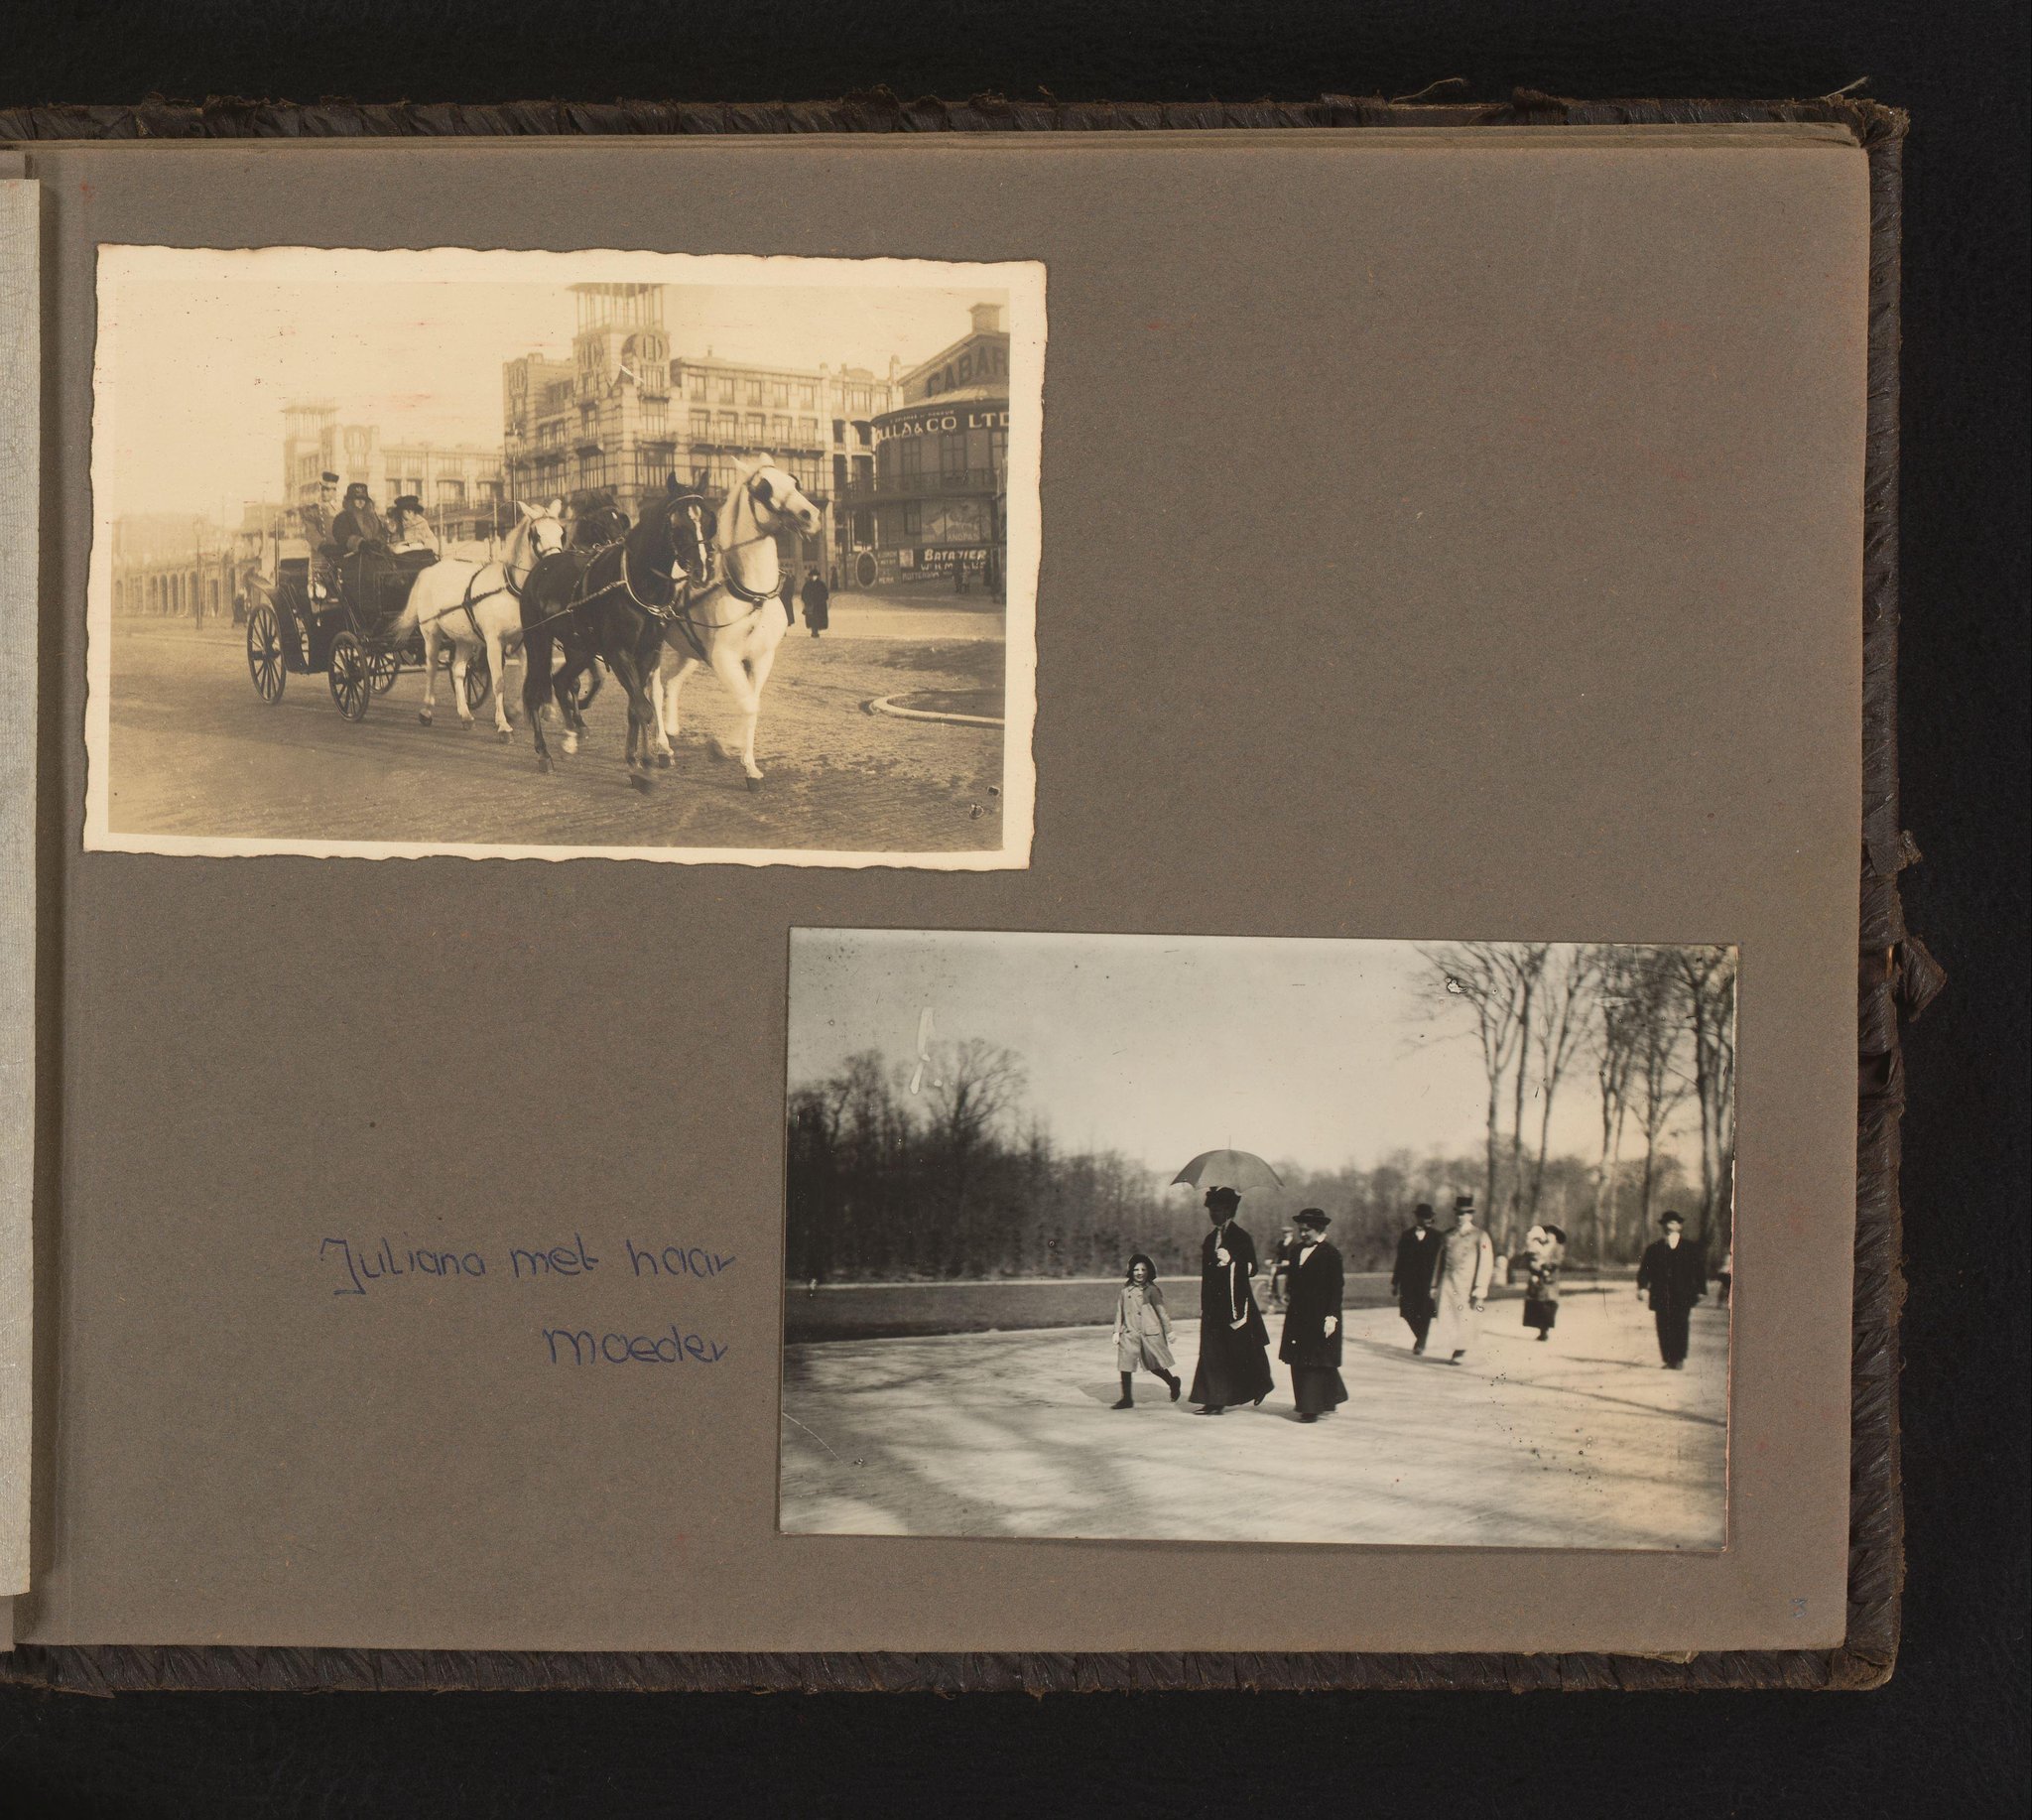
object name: photograph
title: Twee foto's van prinses Juliana als kind, in een rijtuig en wandelend met koningin Wilhelmina en hofhouding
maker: Anonymous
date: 1918-1923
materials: paper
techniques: gelatin silver print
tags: the hague, print maker, wilhelmina of the netherlands, juliana of the netherlands, four-wheeled, animal-drawn vehicle, e.g.: cab, carriage, coach, girl (child between toddler and youth)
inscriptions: annotation: ‘Juliana met haar moeder’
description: Deze foto's maken deel uit van een album.